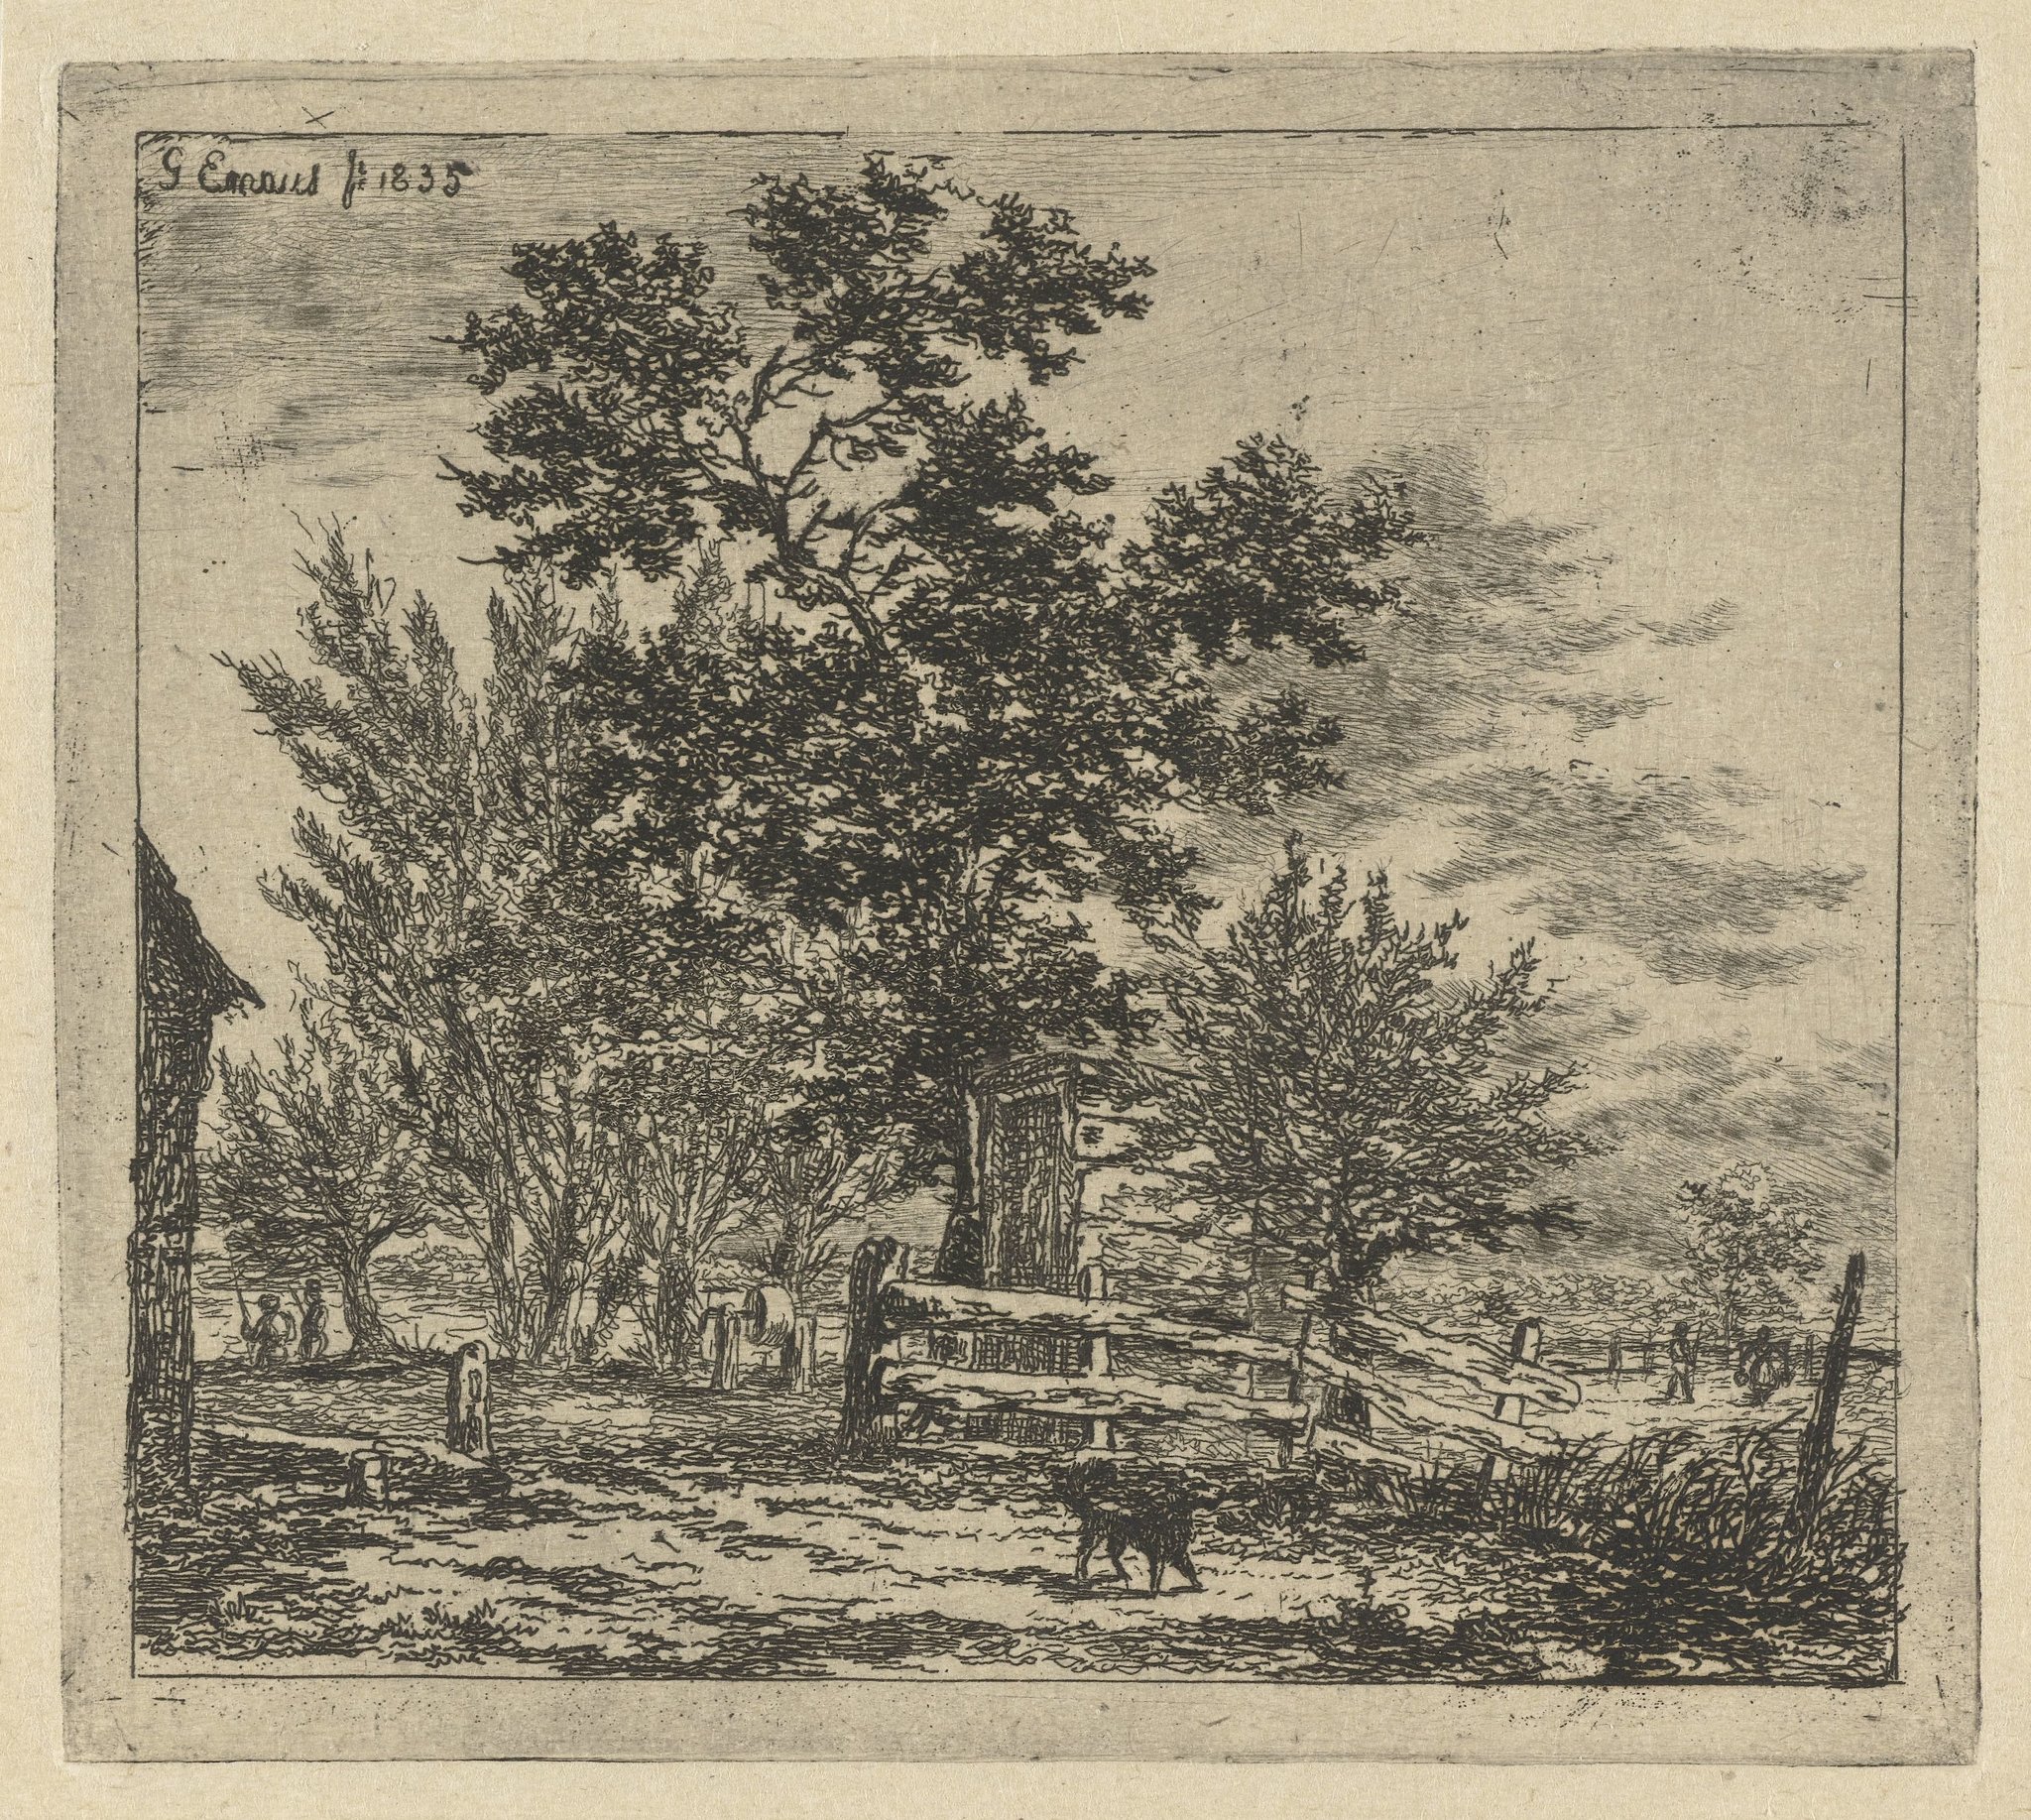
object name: print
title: De hond in het midden van den voorgrond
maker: gerardus emaus de micault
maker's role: draughtsman, print maker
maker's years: 1798-1863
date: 1835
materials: paper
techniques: etching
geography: netherlands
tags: dog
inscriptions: collector's mark: Lugt 2228